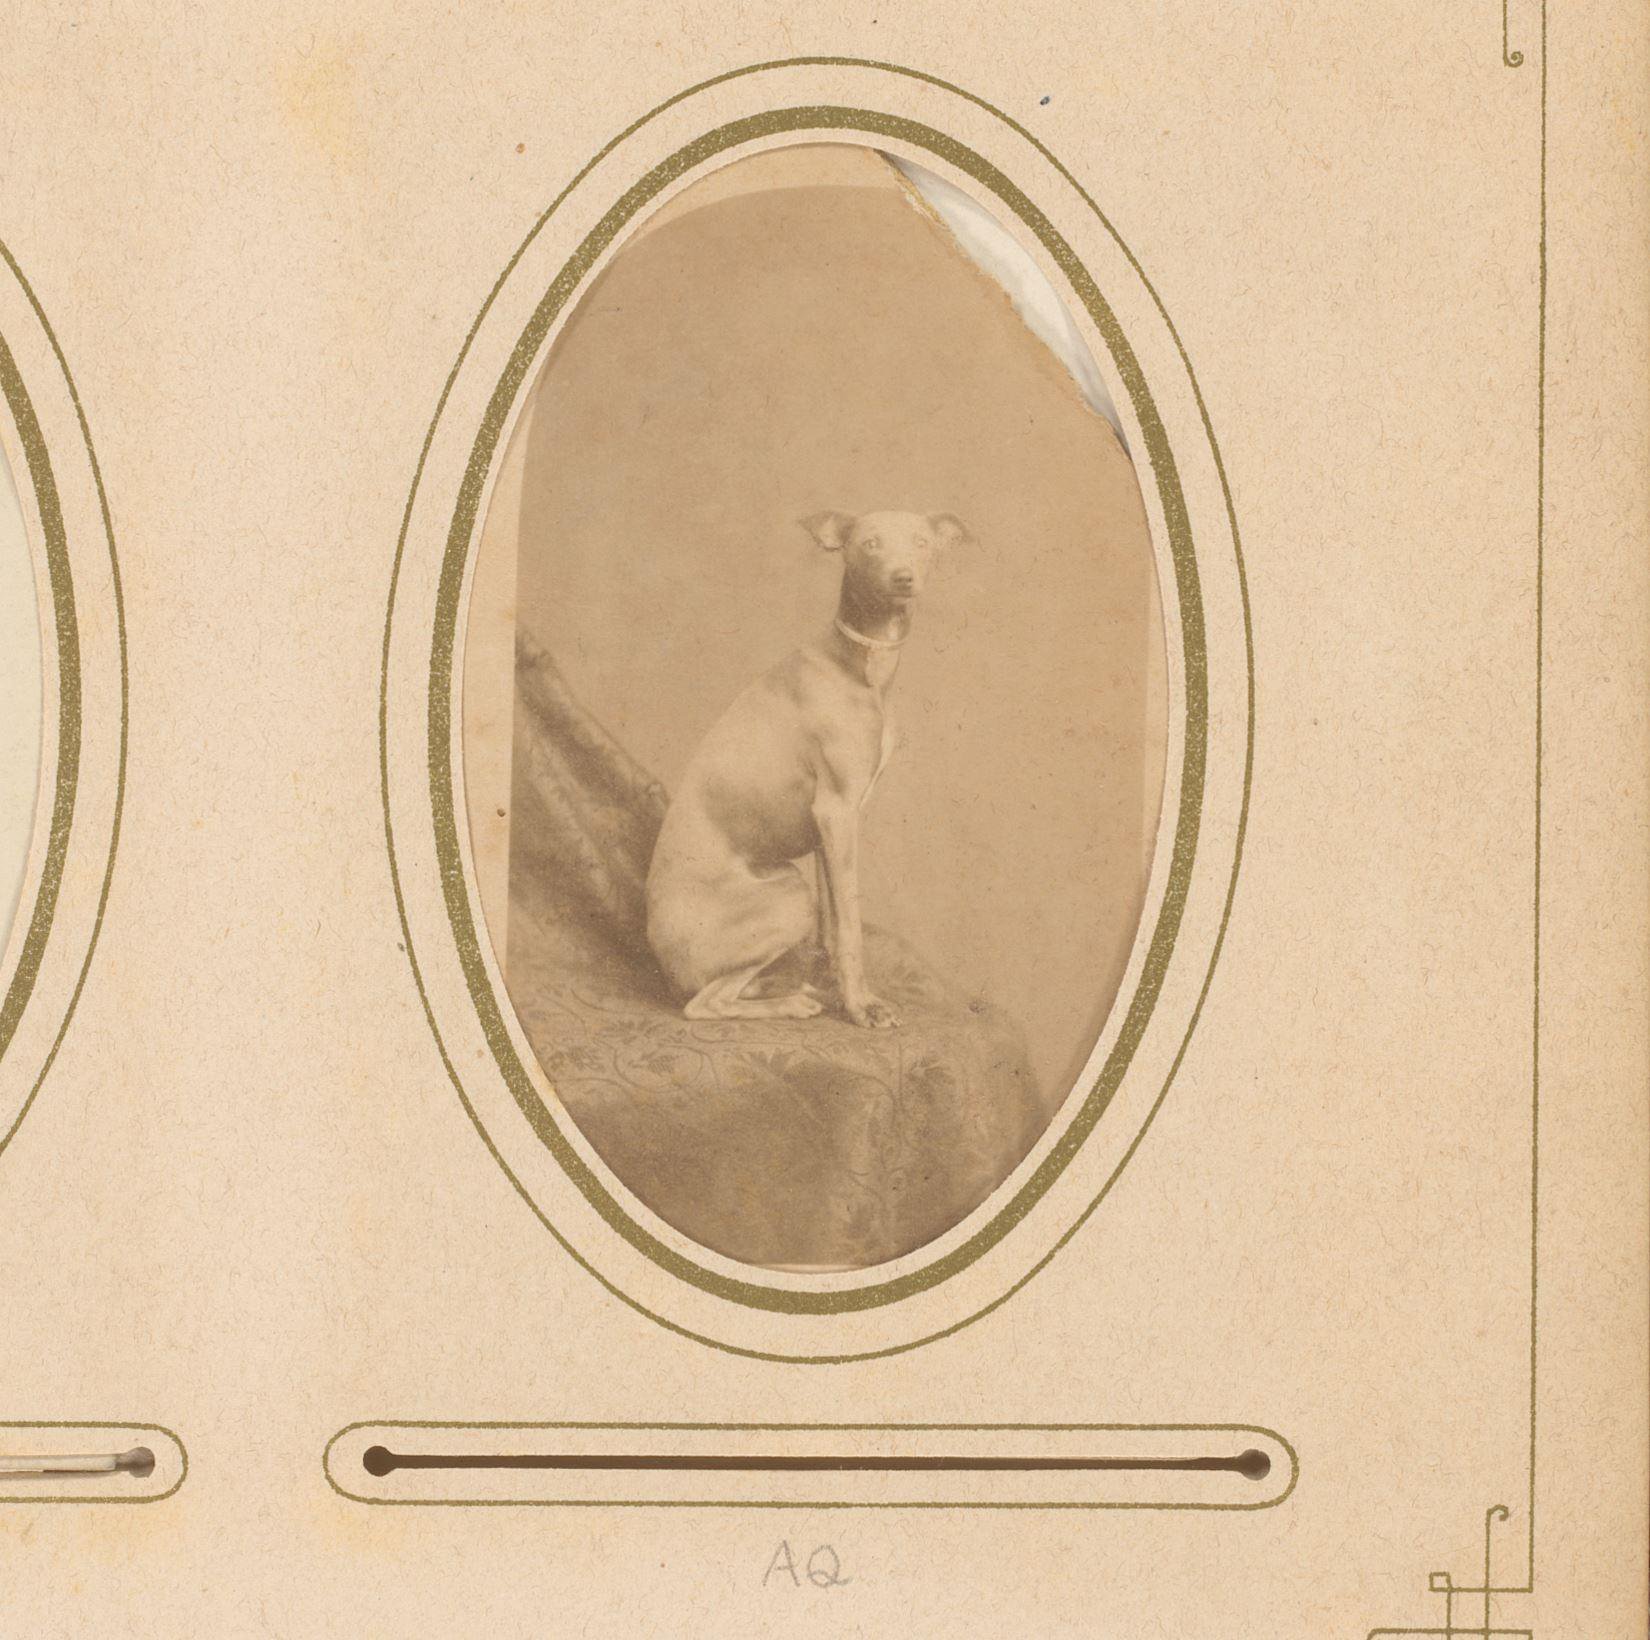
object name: album leaf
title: Zittende hond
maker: leonard stollenwerk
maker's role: fotograaf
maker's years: 1829-1910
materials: cardboard, photographic support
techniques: albumen print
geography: den bosch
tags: dog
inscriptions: inscription: ‘Photographie/ van/ L. Stollenwerk/ 's BOSCH./ Het negatif blijft voor nabestellingen bewaard.’